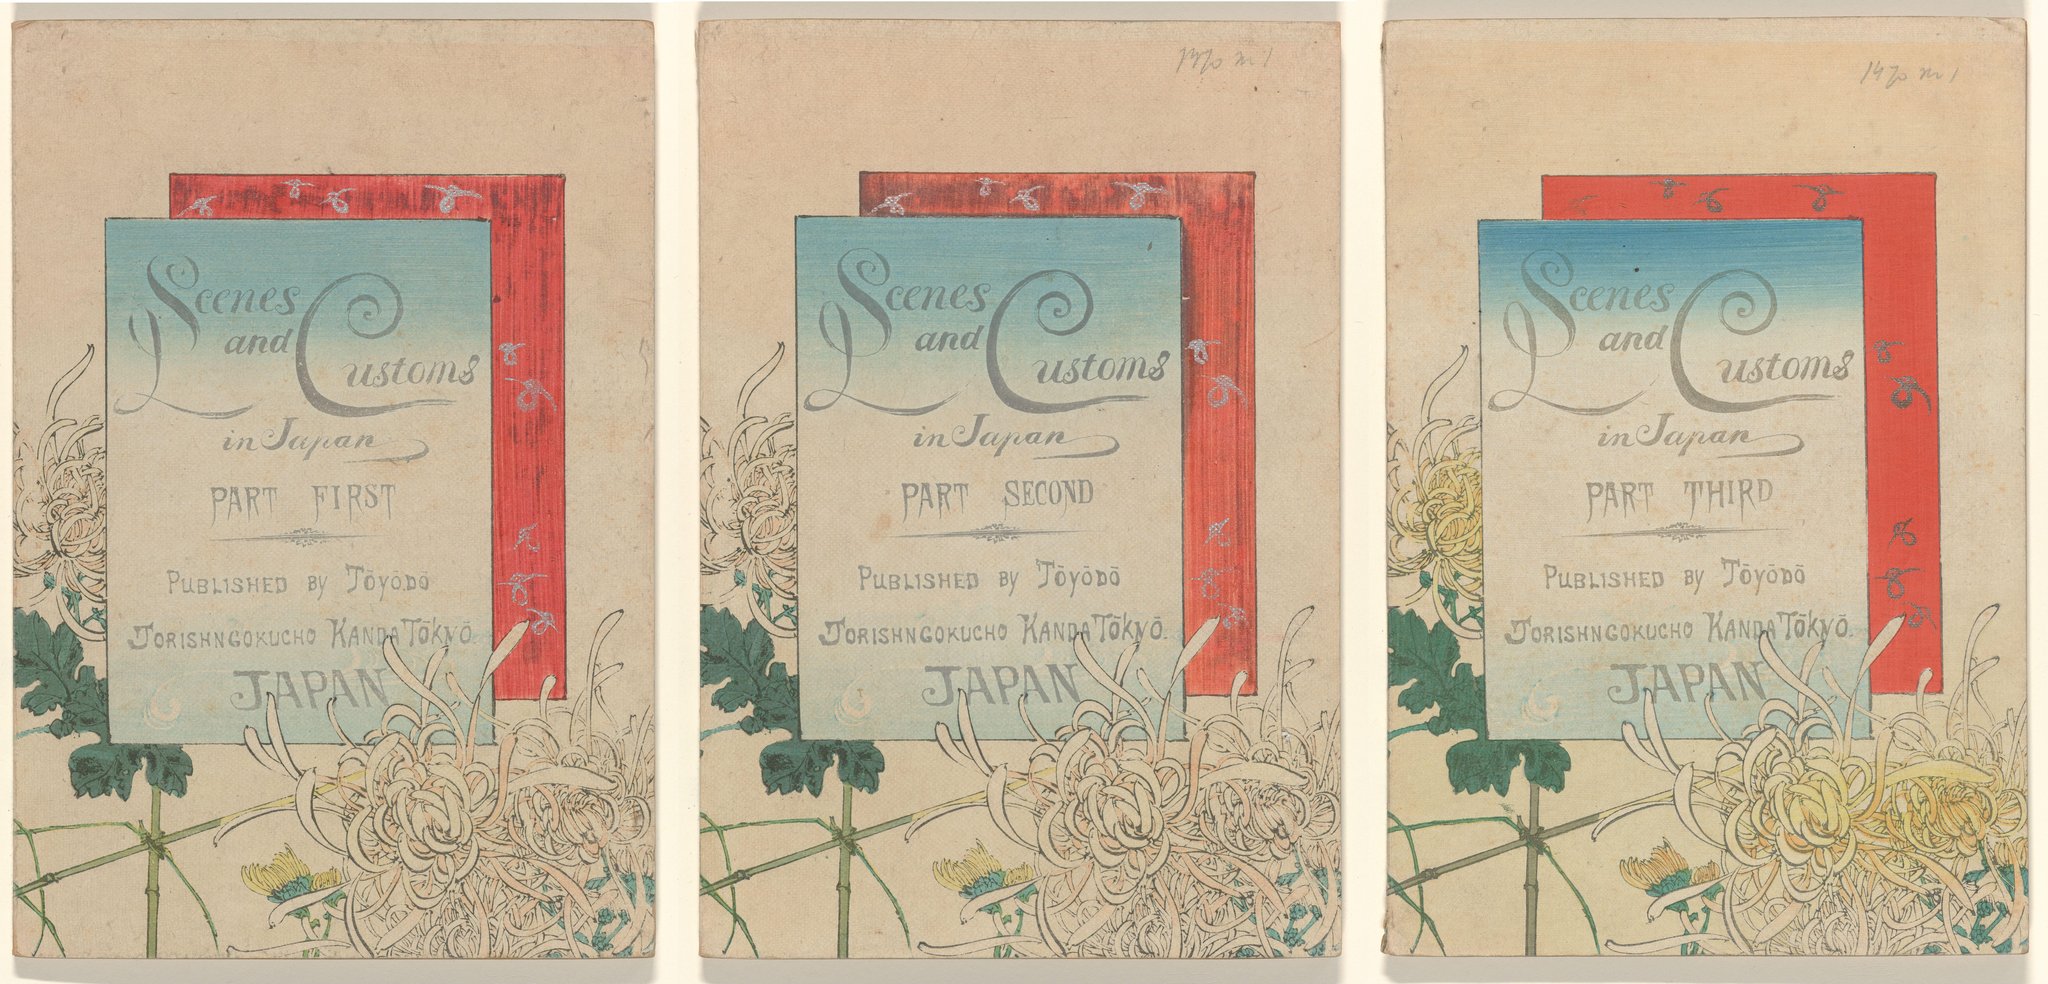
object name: book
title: Scenes and customs in Japan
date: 1902-1904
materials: paper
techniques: lithograph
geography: japan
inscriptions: date